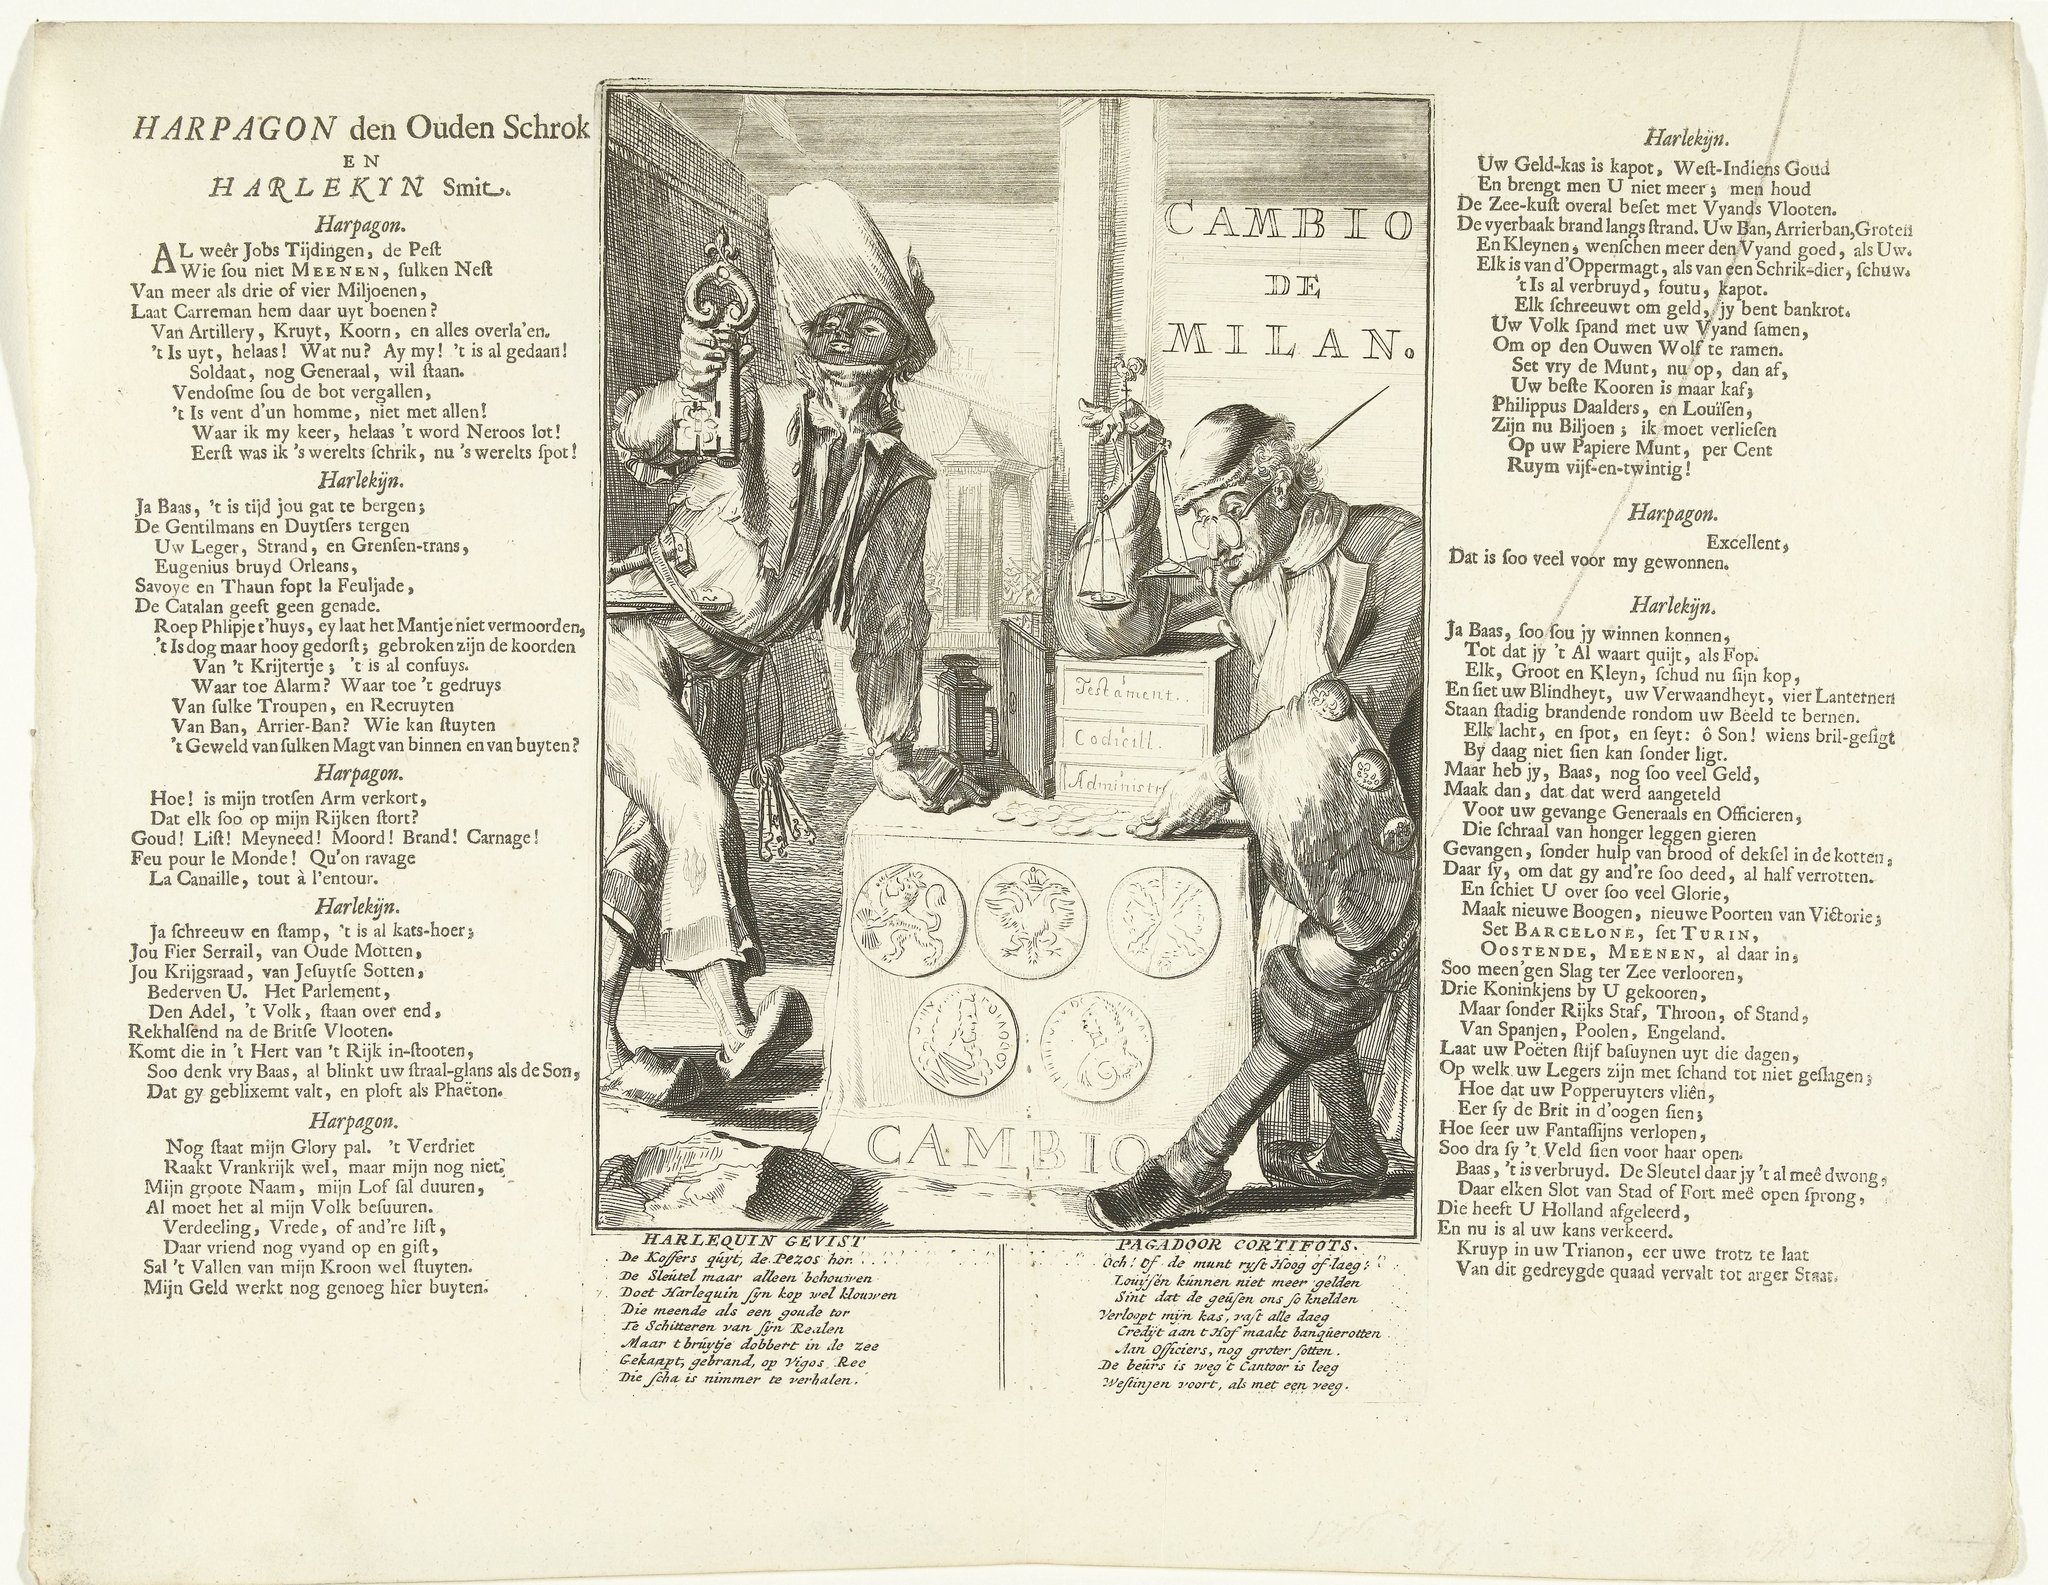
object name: cartoon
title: Koninklijke Almanach van 1701 / 't Lusthof van Momus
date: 1706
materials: paper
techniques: etching, letterpress printing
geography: amsterdam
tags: lodewijk xiv (koning van frankrijk), money-changer, political caricatures and satires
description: Wisselkantoor van Milaan waarin koning Lodewijk XIV (Harpagon) geld afweegt voor Harlekijn die voor hem staat, gemaskerd en met een sleutel in de hand. Met twee verzen in het Nederlands in het onderschrift en een vers in het Nederlands op het blad aan weerszijden van de plaat. Onderdeel van een reeks van 19 spotprenten op de Fransen en bondgenoten uit het jaar 1706.